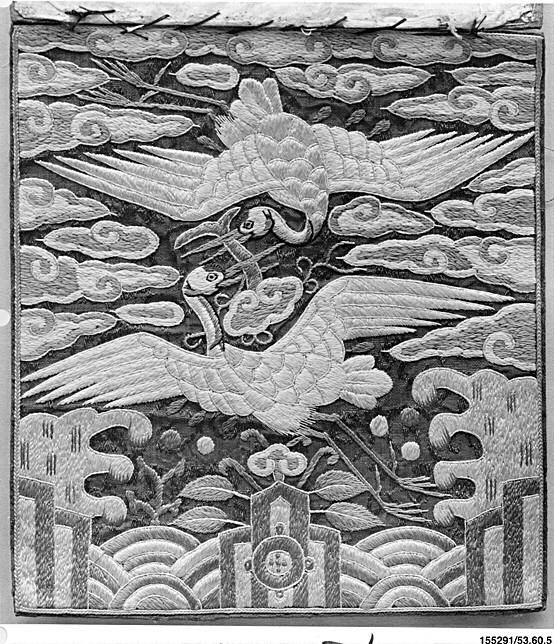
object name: rank badge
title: Rank Badge with Decoration of Two Cranes among Clouds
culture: korean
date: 1801-1900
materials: silk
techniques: damask, embroidery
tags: cranes